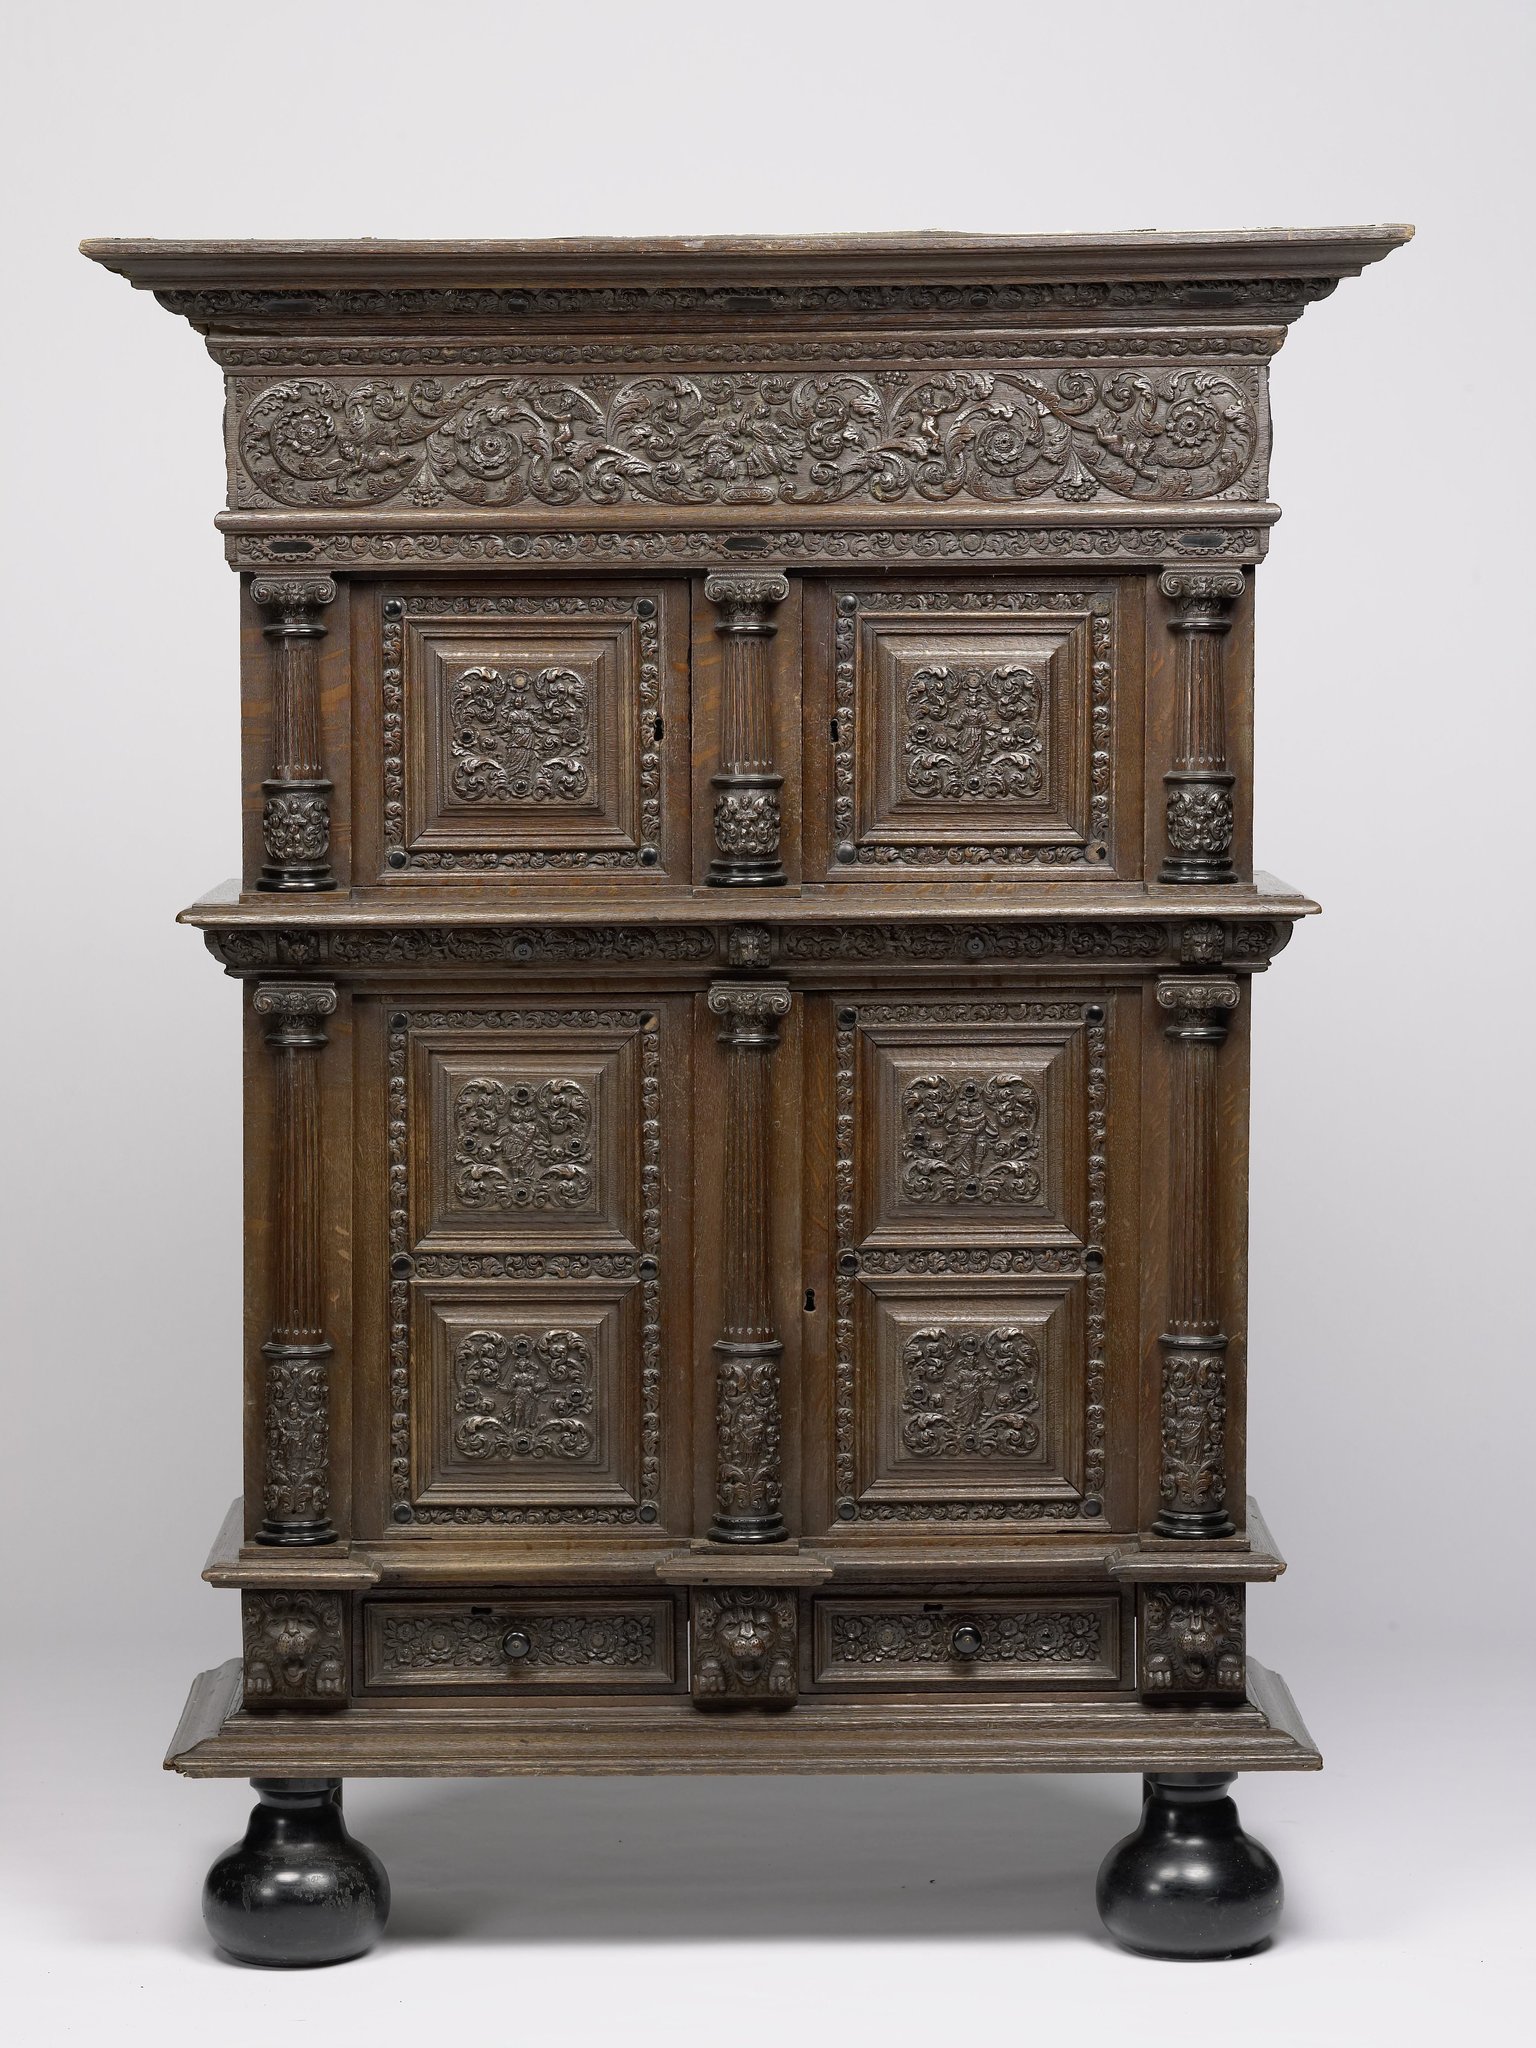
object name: case furniture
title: Kast met vier deuren met gesneden, godsdienstige voorstellingen.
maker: Anonymous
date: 1630-1660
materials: wood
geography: netherlands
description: Eikenhouten kast, met onder- en bovenbouw. De vier deuren zijn geplaatst tussen gecanneleerde halve zuilen met versierde schachtvoet, rustend op verkroppingen in het basement, versierd met leeuwekoppen. Op de deurpanelen zijn godsdienstige voorstellingen (Gen. 18) uitgebeeld; het brede fries vertoont acanthusranken. Onderaan bevinden zich twee laden.